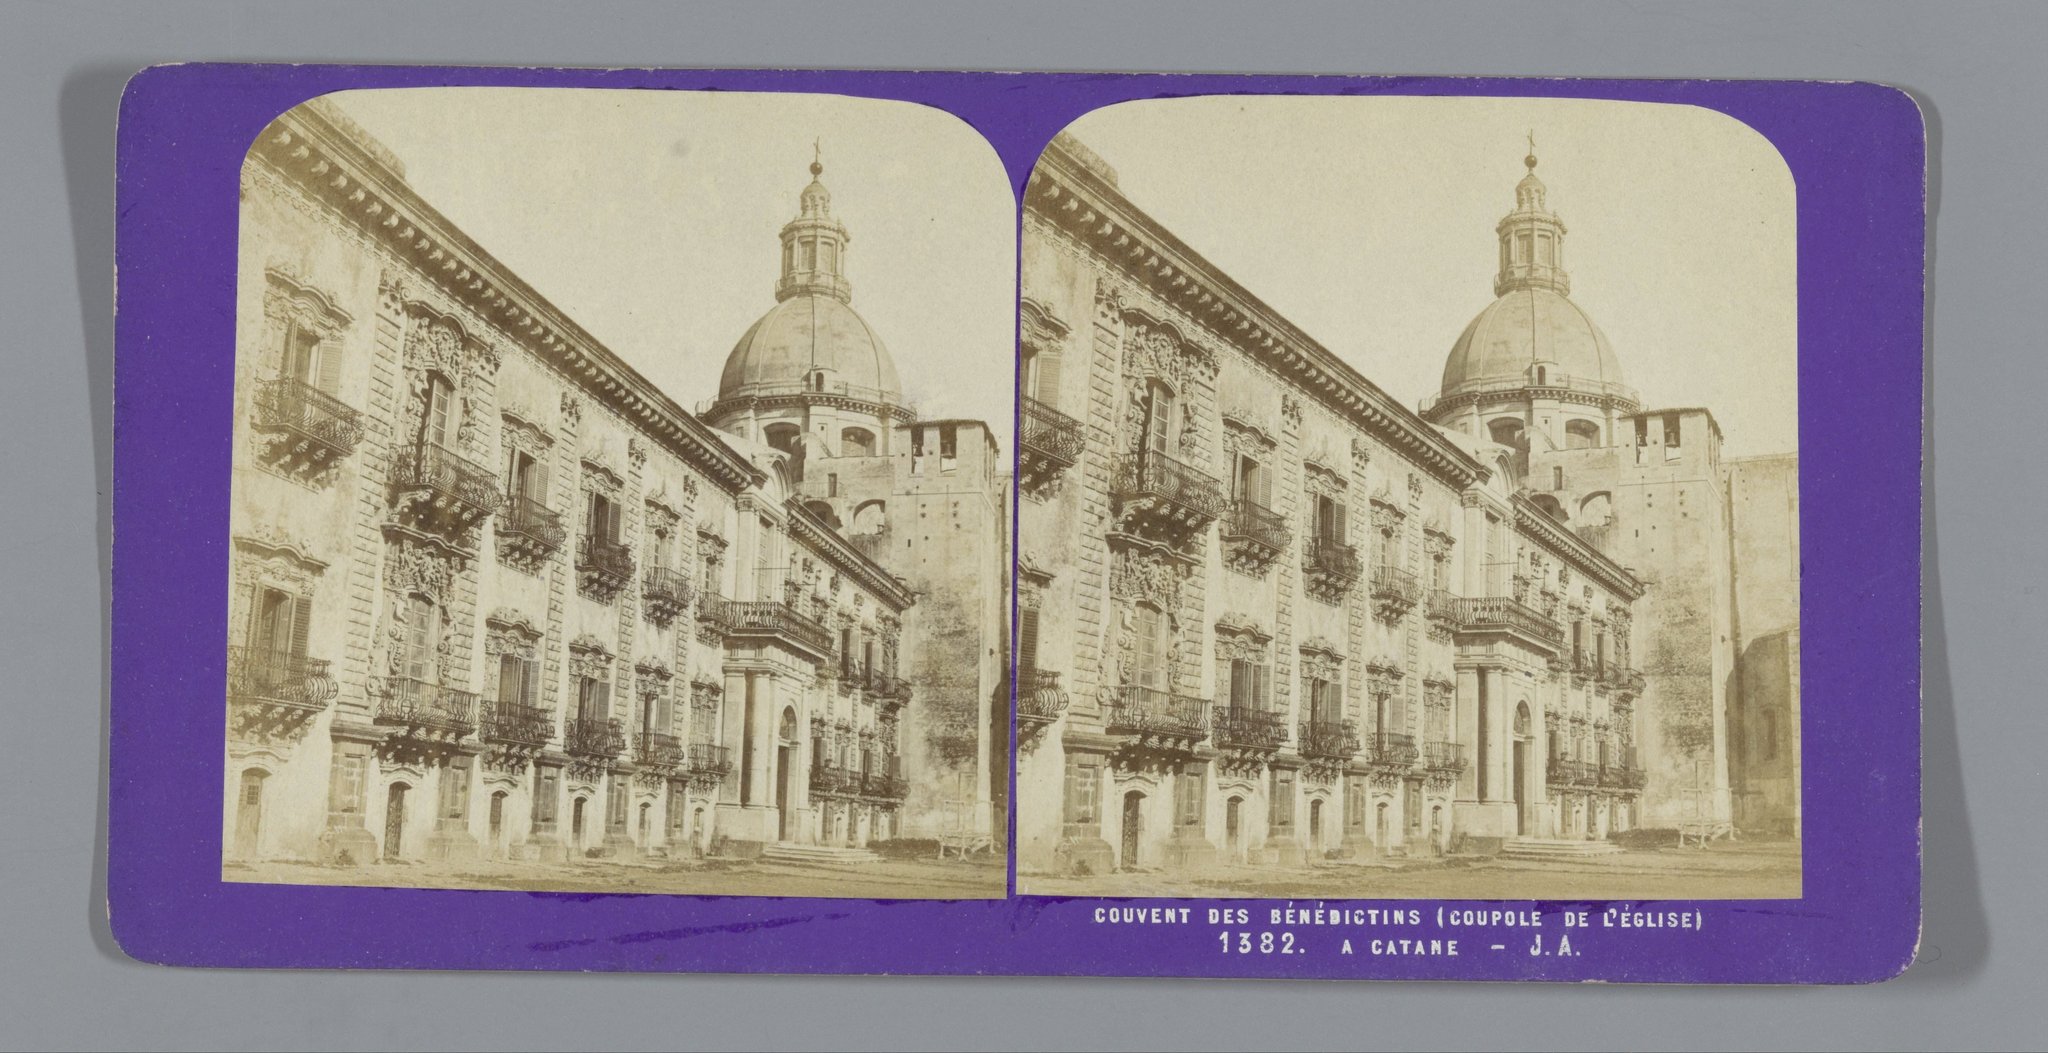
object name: stereograph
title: Couvent des Bénédictins (coupole de l'église) a Catane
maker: jean andrieu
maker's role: fotograaf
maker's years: 1816-1872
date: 1862-1876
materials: cardboard, paper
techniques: albumen print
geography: catania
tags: cloisters ~ monastery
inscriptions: number: ‘1382’